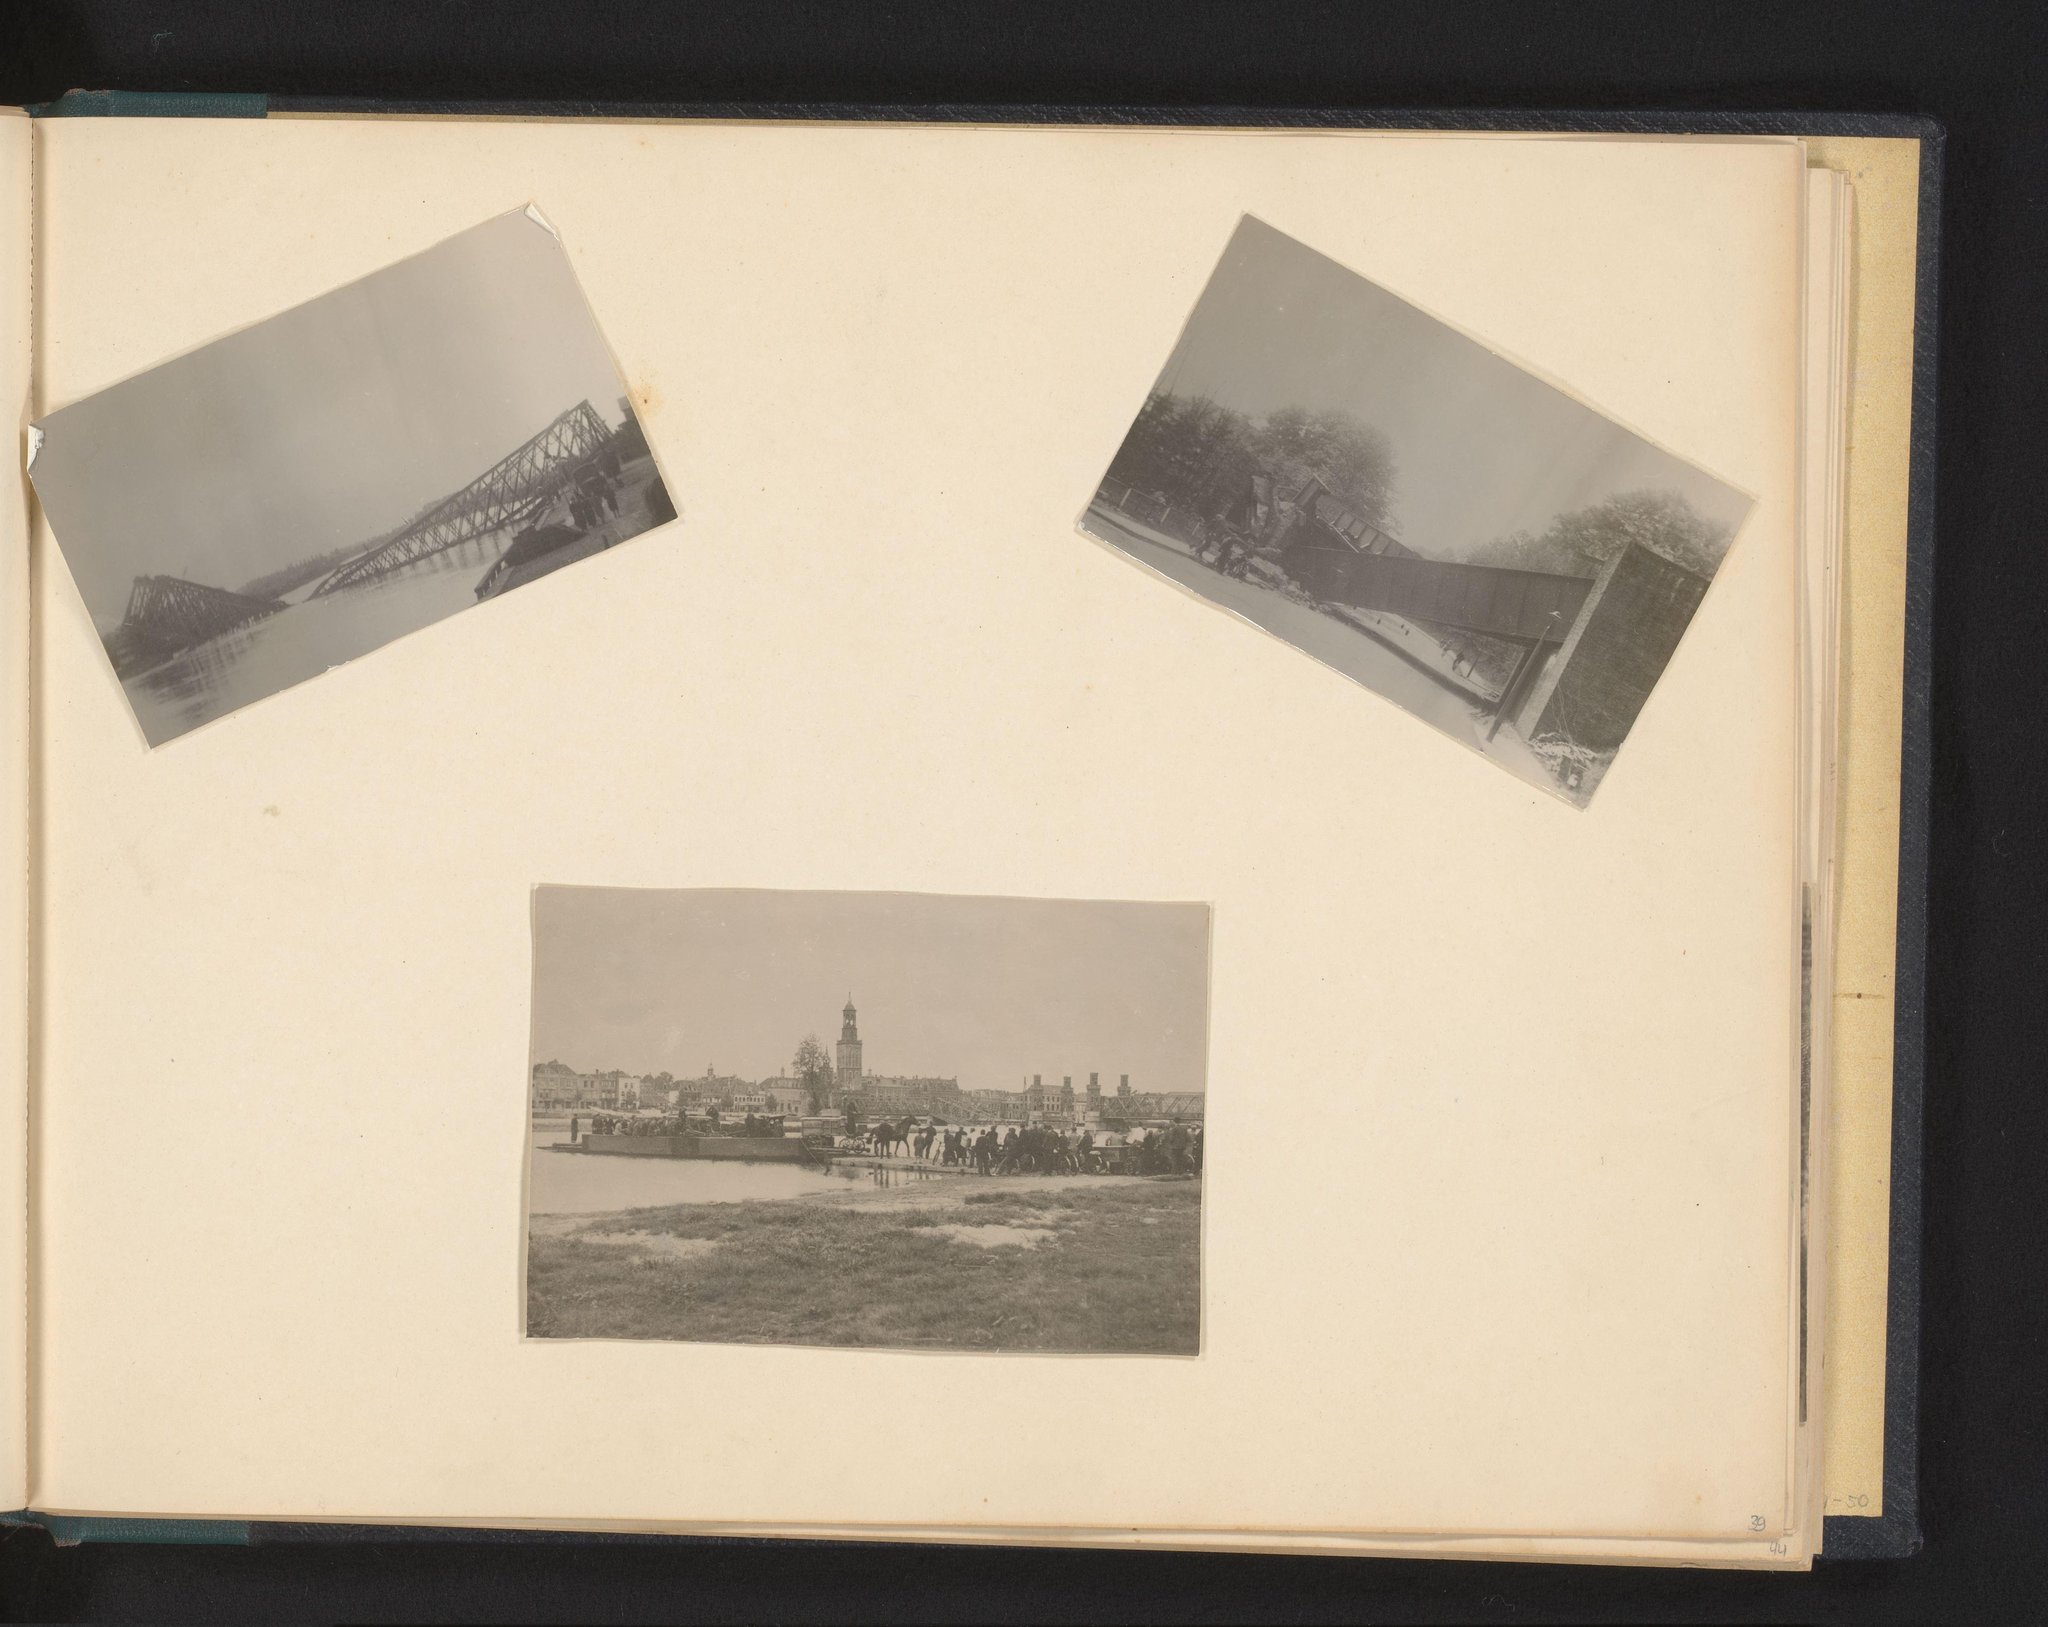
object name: photograph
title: Verwoeste bruggen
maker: arnoldus vrauwdêunt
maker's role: graficus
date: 1940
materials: cardboard, photographic support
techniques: gelatin silver print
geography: deventer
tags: ferry, devastated, ruined place or city (~ warfare), bridge, netherlands, deventer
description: Albumblad met drie foto's van de verwoeste spoorbrug te Deventer, een verwoeste brug of viaduct en de veerboot over de IJssel te Deventer ter vervanging van de verwoeste bruggen, waarschijnlijk mei 1940. Onderdeel van het fotoalbum over de verwoestingen van Nederlandse steden en infrastructuur in het begin van de Tweede Wereldoorlog.